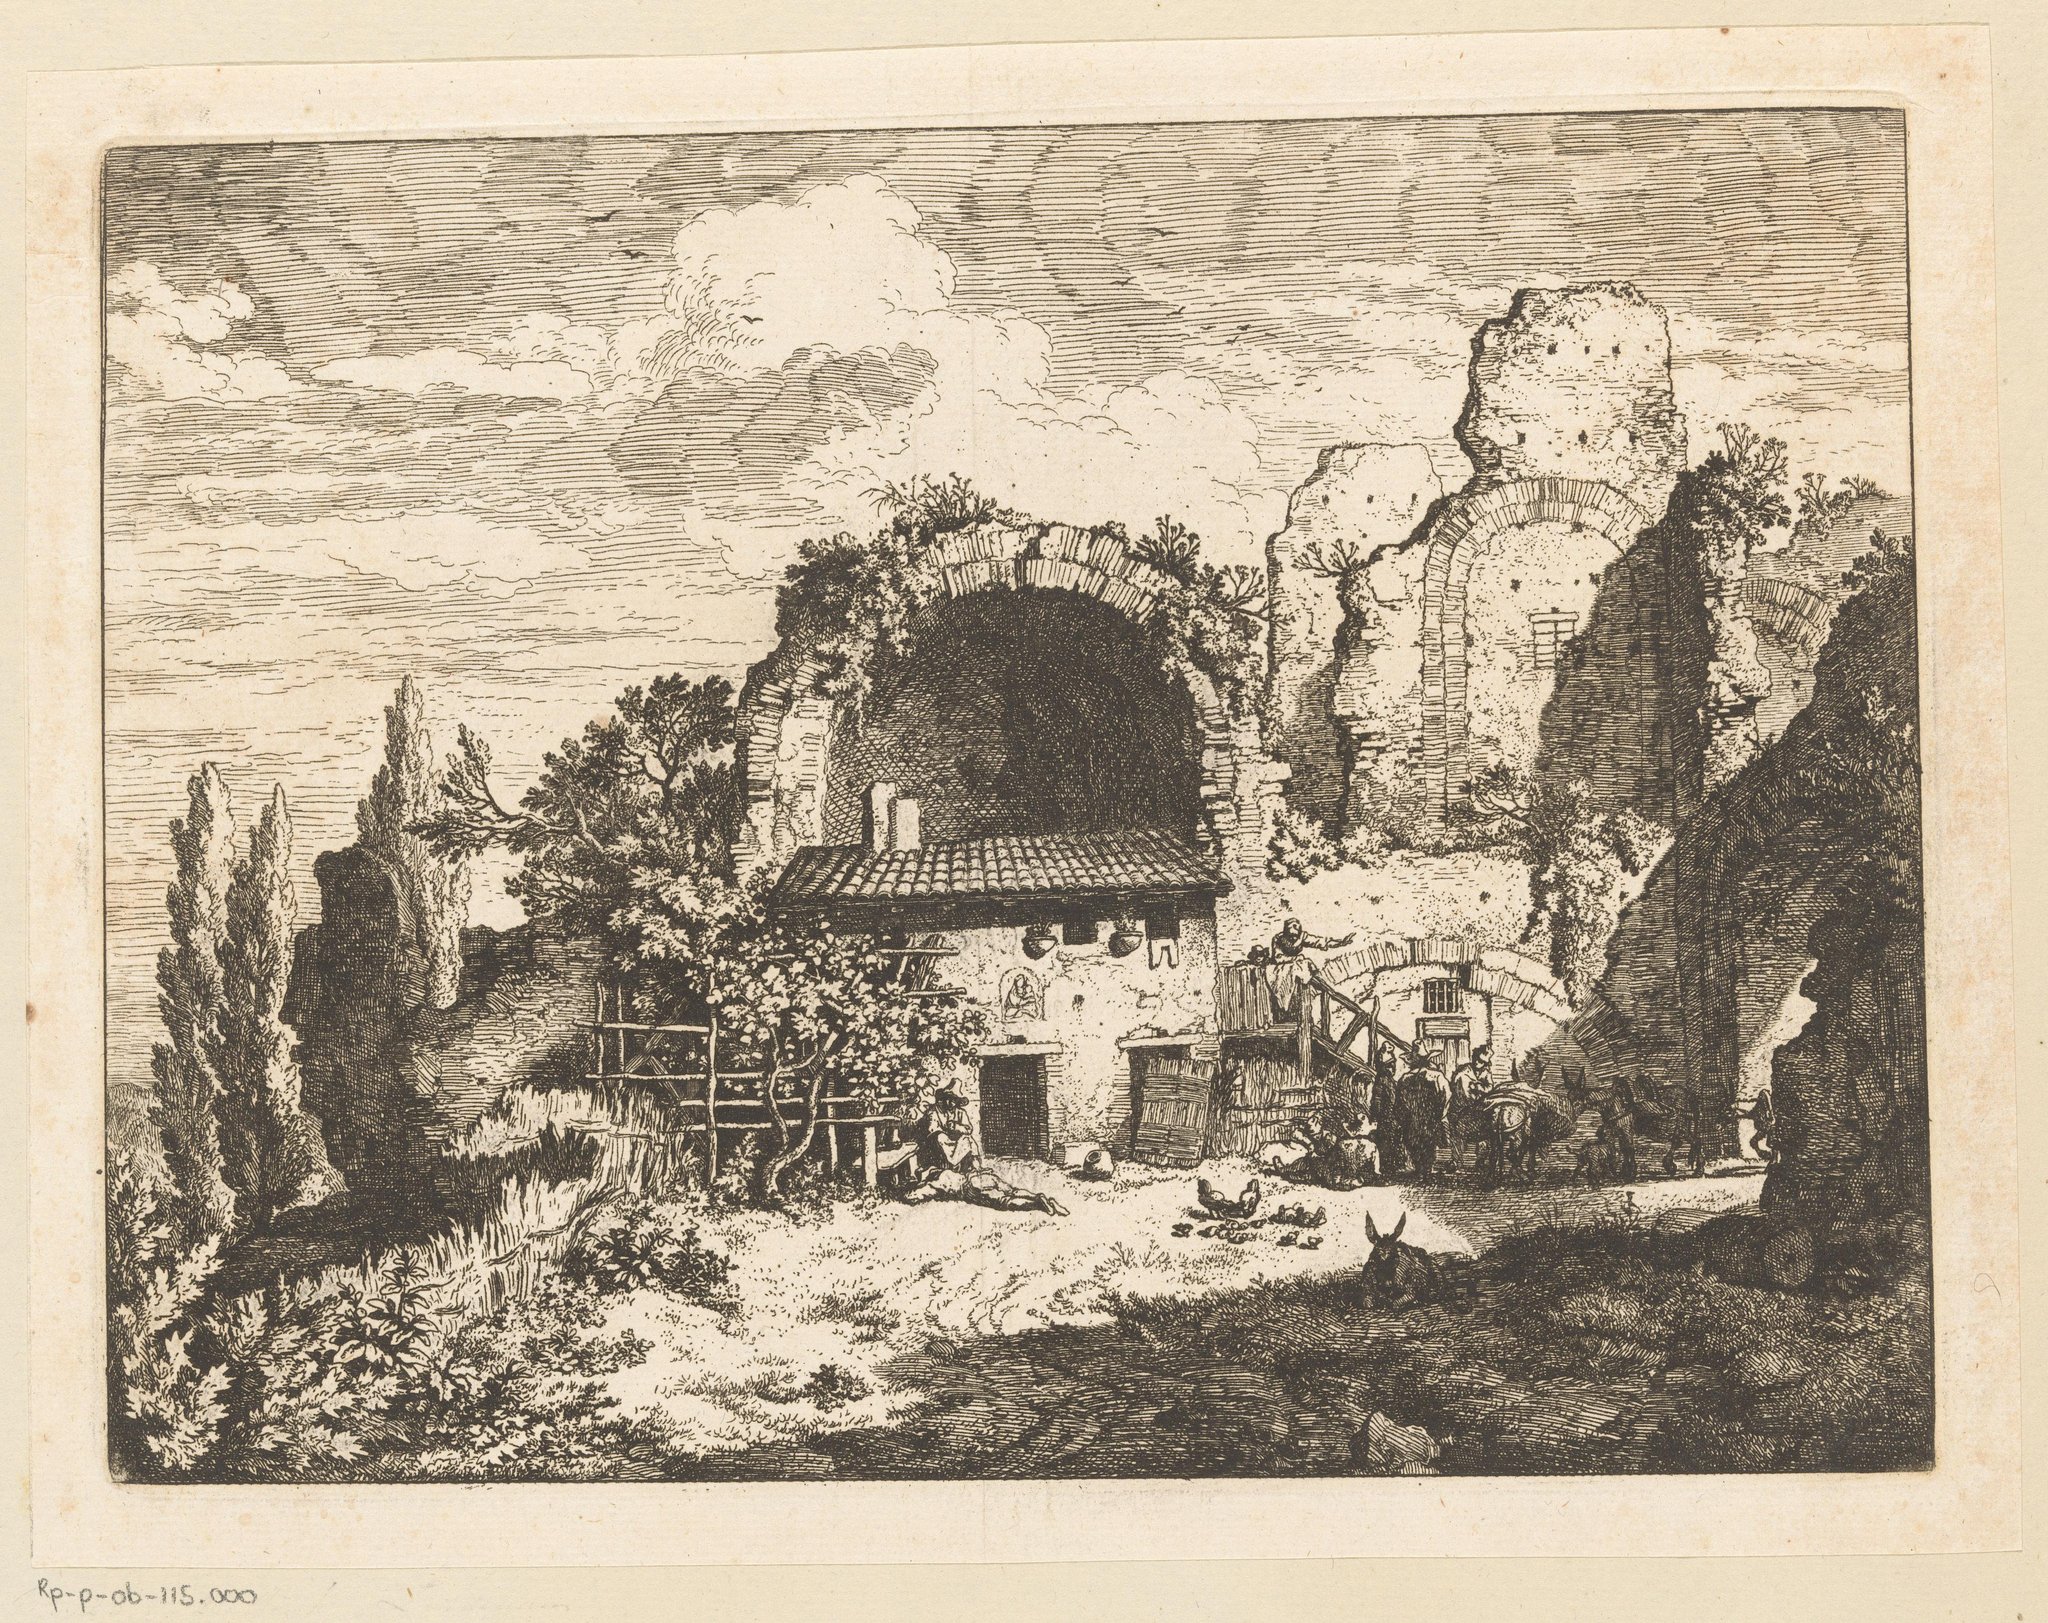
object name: print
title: Landschap met herberg en ruïnes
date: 1722-1774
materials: paper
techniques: etching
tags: city-view, and landscape with man-made constructions, madonna: i.e. mary with the christ-child, drunkard, landscape with ruins, mule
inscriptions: collector's mark: Lugt 240